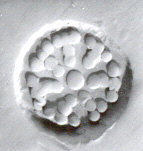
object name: stamp seal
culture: bactria-margiana archaeological complex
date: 2333-1668 BCE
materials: lapis lazuli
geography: bactria-margiana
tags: flowers